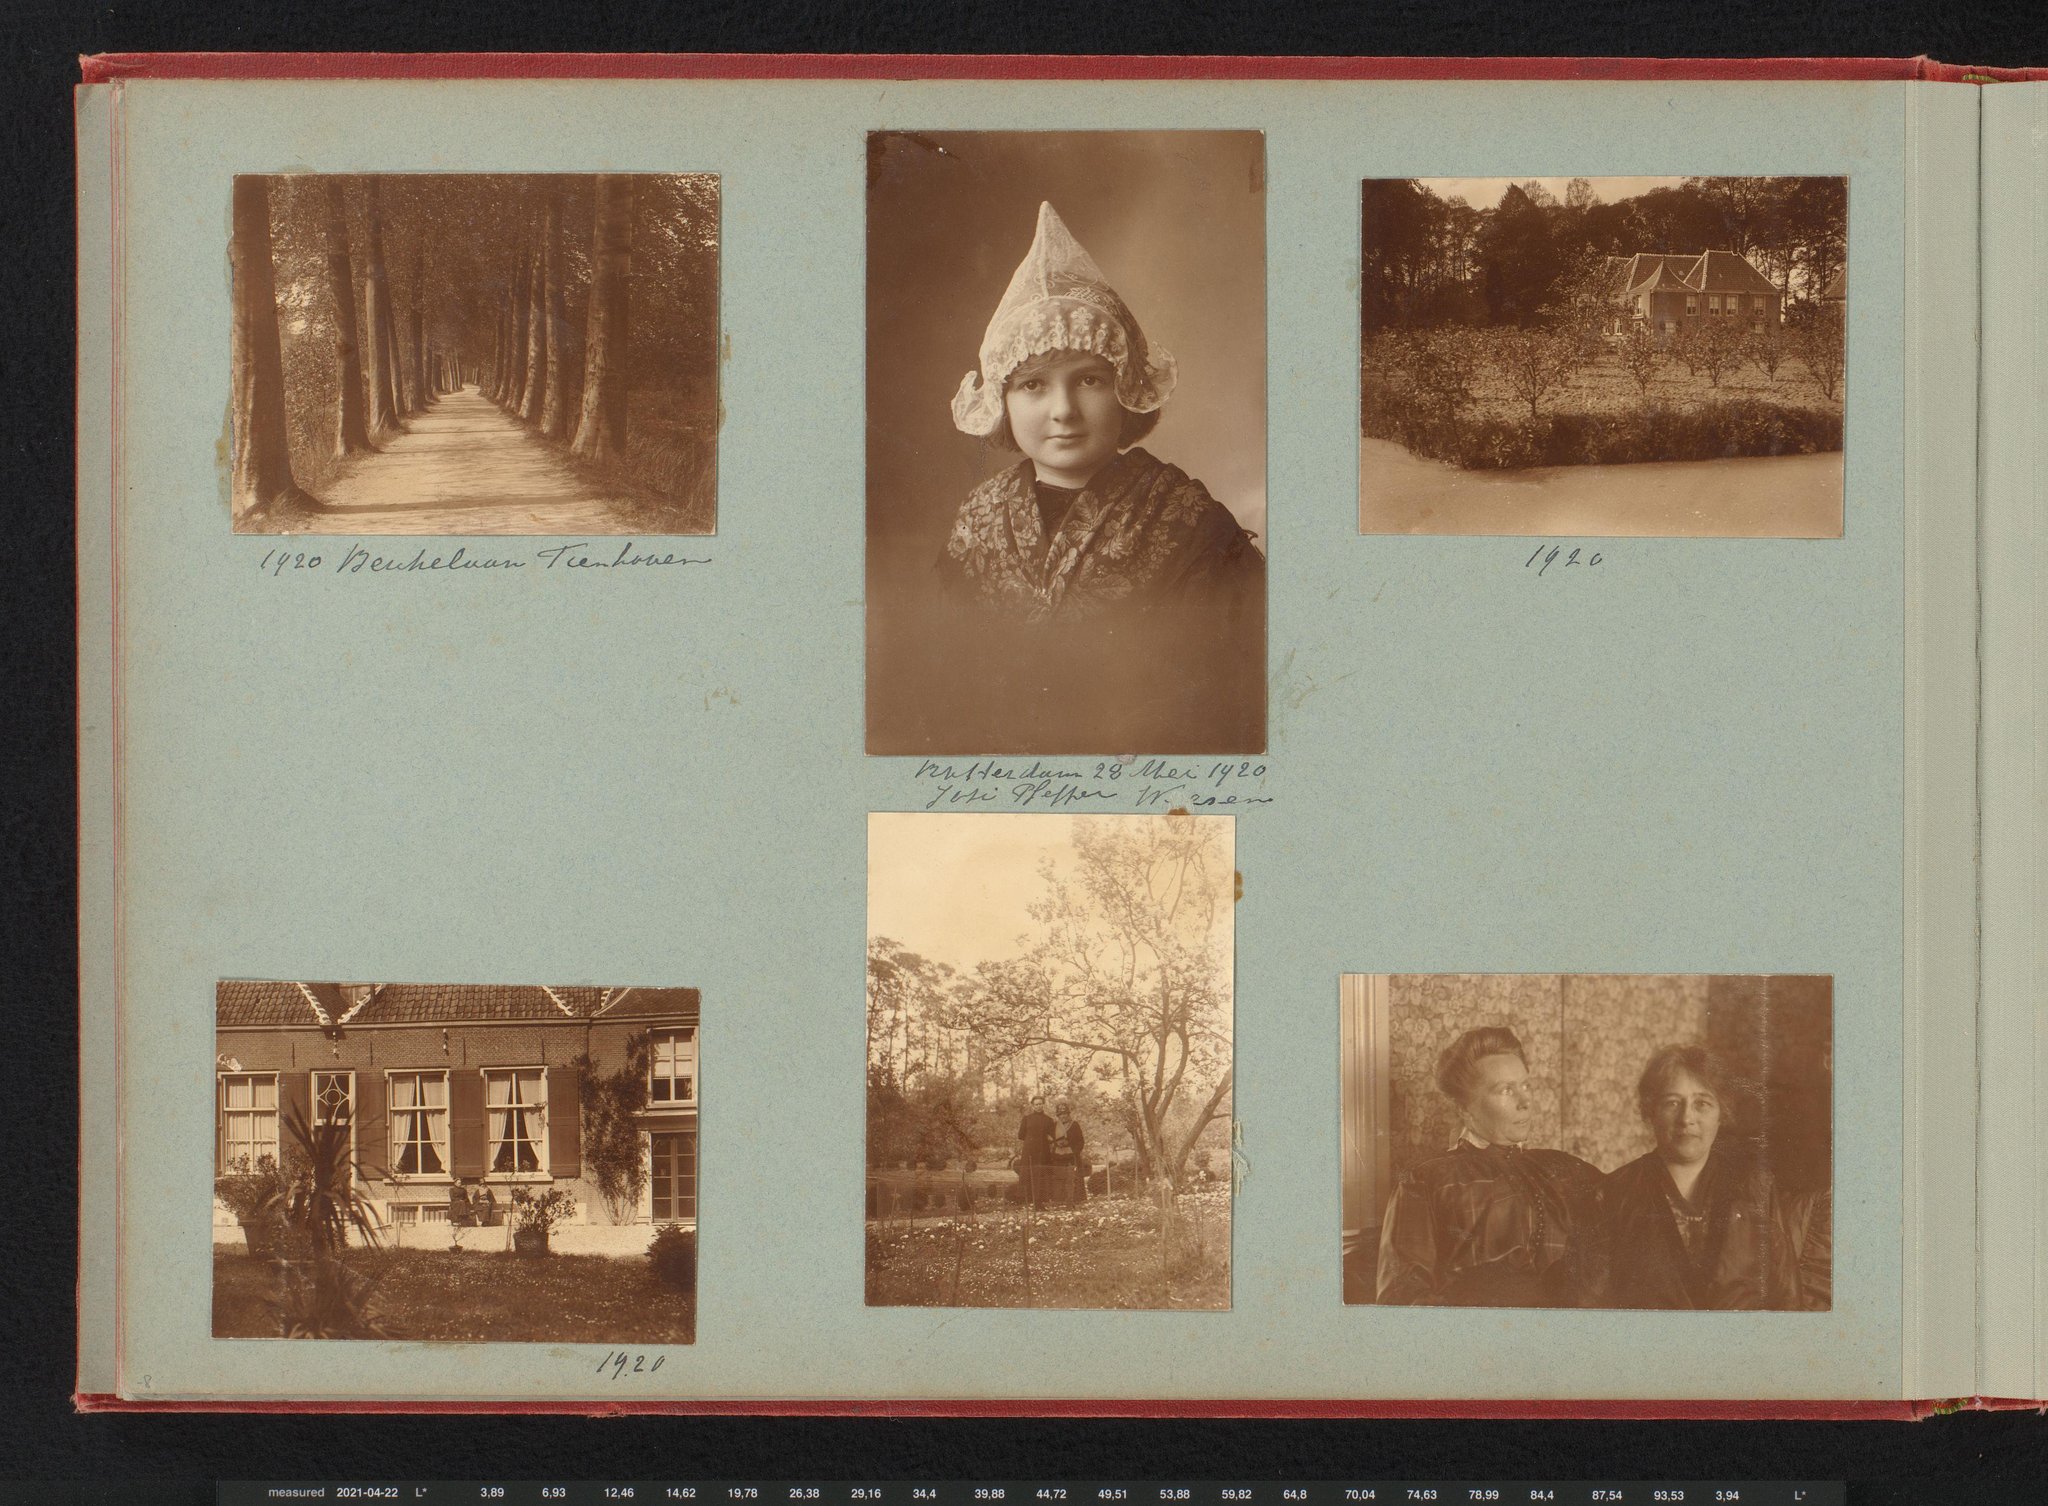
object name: album leaf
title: Gezicht op een landhuis en twee portretten van onbekende mensen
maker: Anonymous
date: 1920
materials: paper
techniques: gelatin silver print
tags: rural housing, e.g. country-house, villa, cottage, anonymous historical person portrayed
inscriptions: inscription: ‘Rotterdam 28 mei 1920/ Josi Pfeffer W[...]rsen’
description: Deze foto's zijn onderdeel van een album.